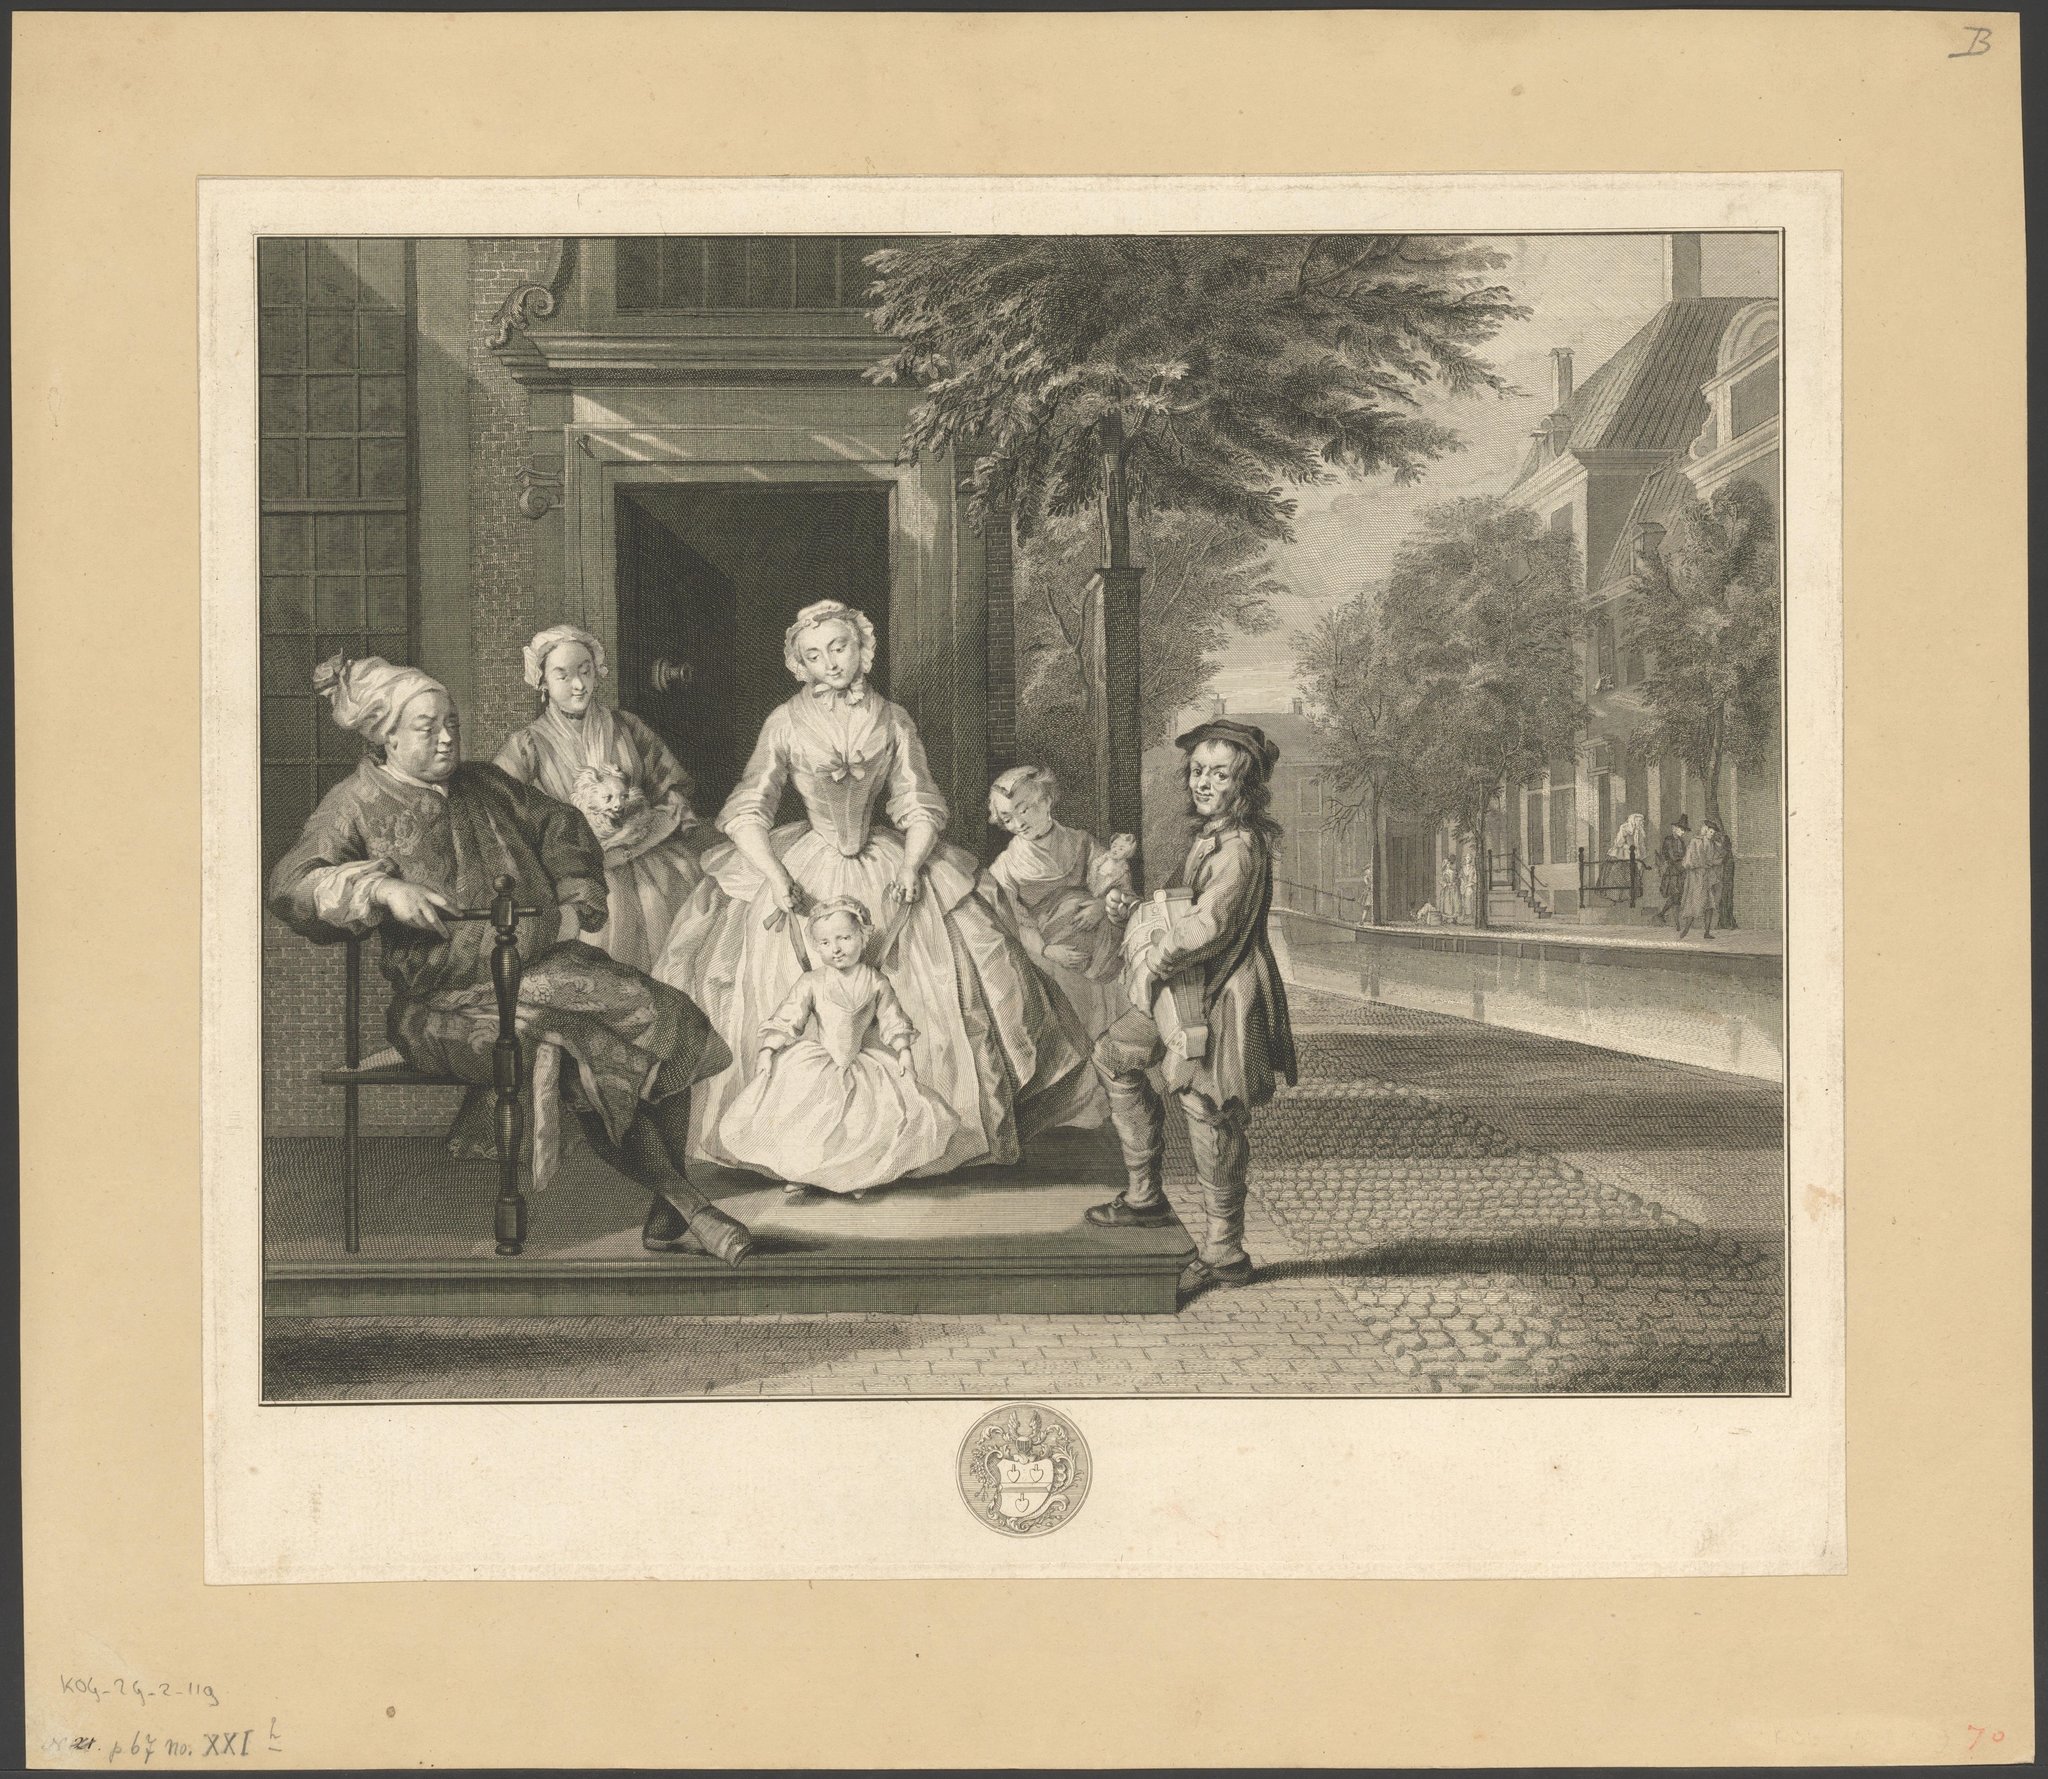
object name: print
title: De liereman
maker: jacob houbraken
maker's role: draughtsman, print maker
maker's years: 1698-1780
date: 1764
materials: paper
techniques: engraving, etching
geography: netherlands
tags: parents with their children, hurdy-gurdy player - cc - out of doors, canals, waters (in city) (+ city(-scape) with figures, staffage)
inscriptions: collector's mark: Lugt 2488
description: Op een stoep voor een deuropening in een stad zit een gezin waaronder twee jonge kinderen. Naast hen staat een straatmuzikant met een draailier. Rechts een gracht. Staat vóór de letter.